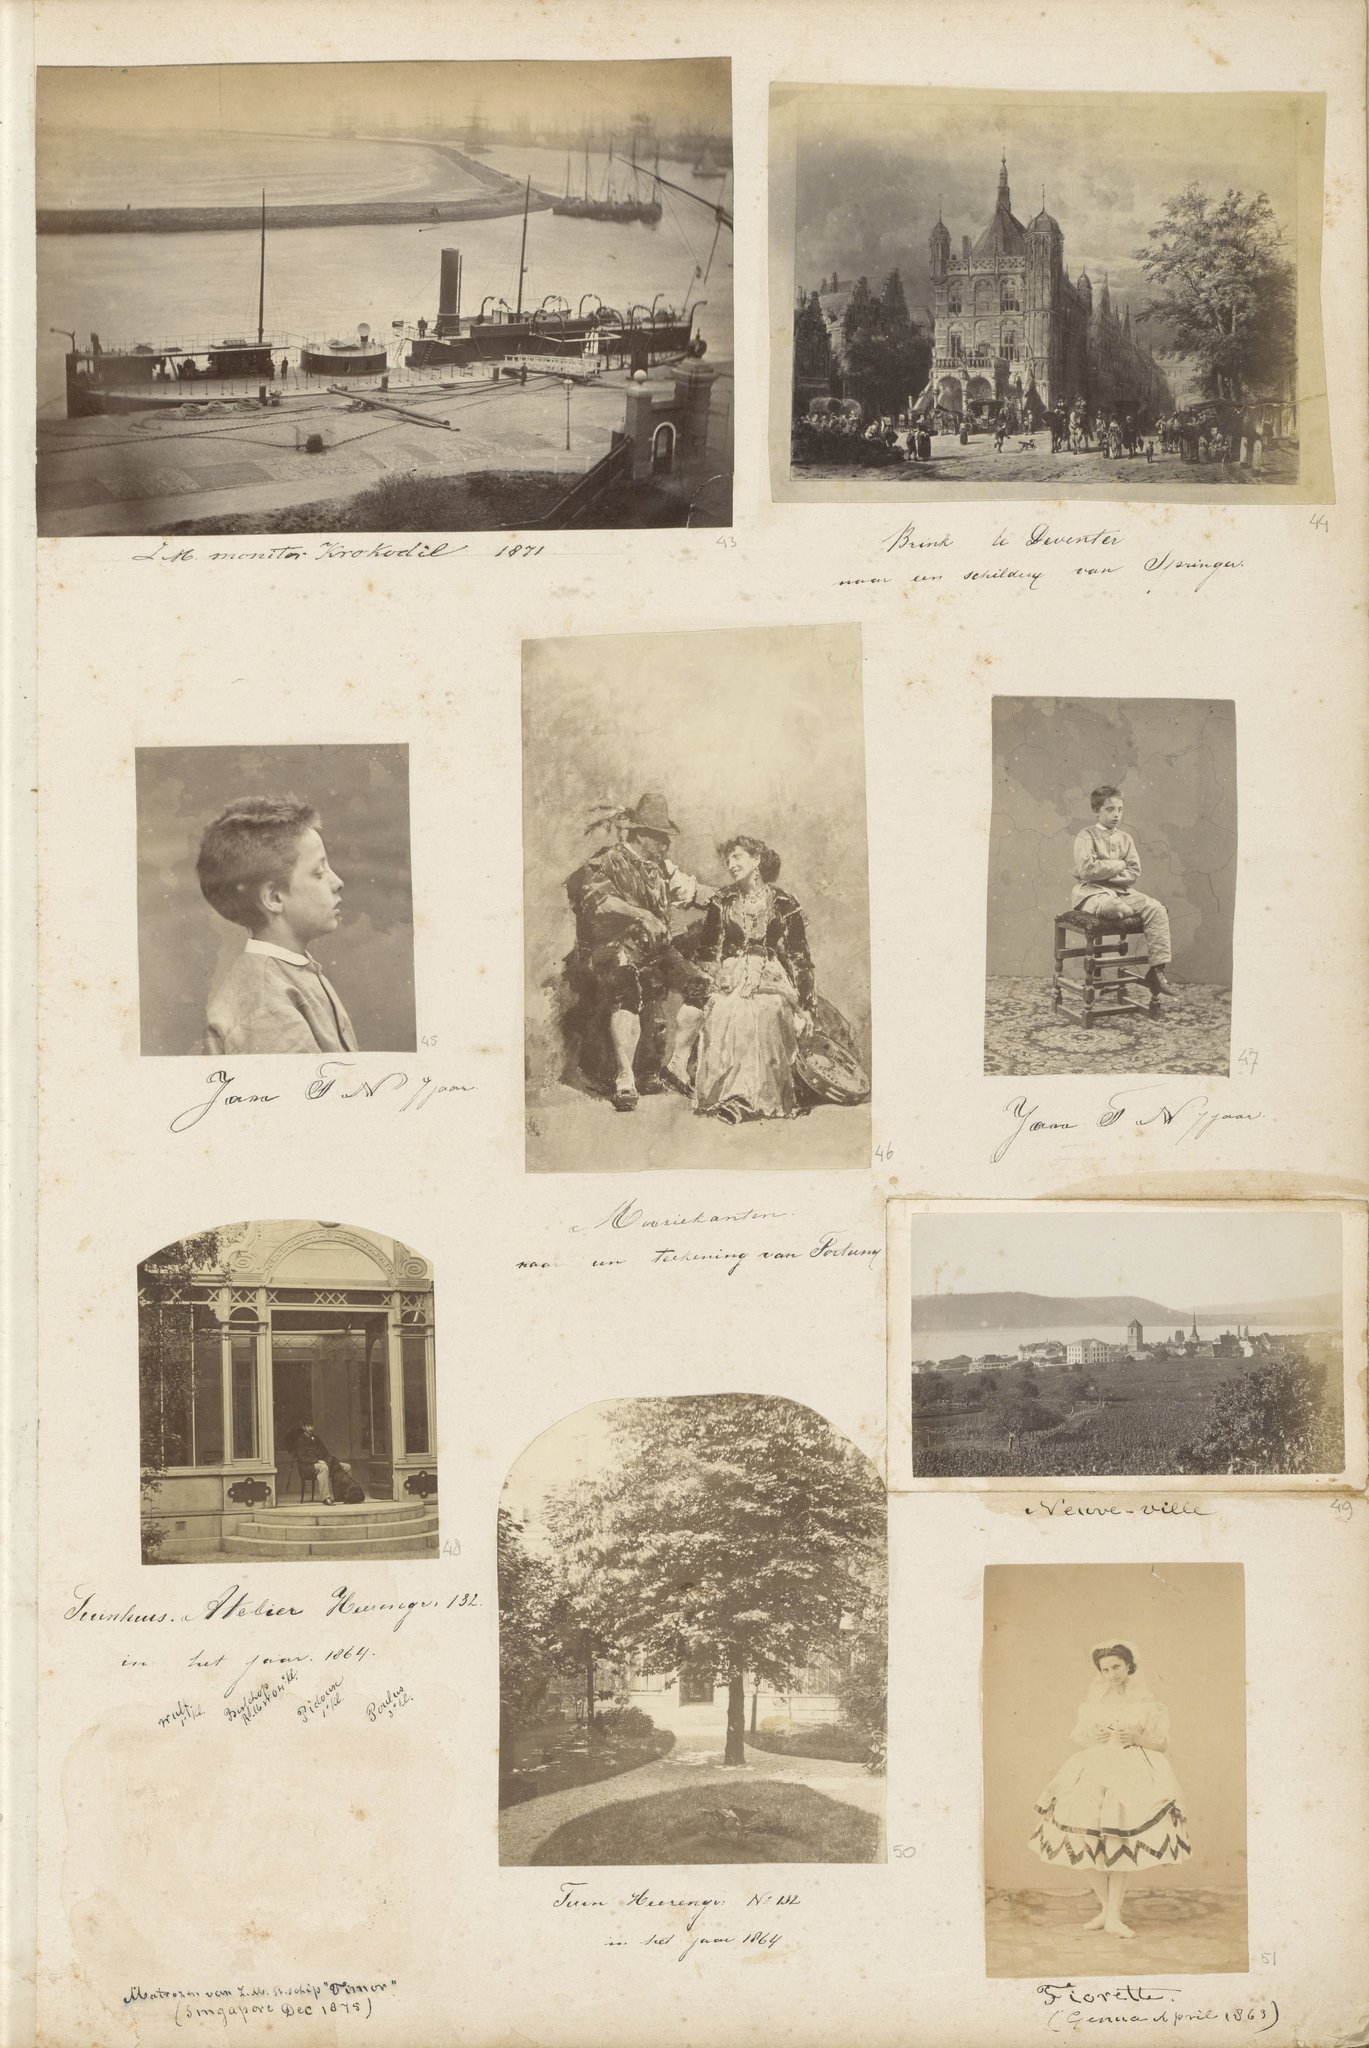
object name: album leaf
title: Portret van een vrouw in een wijduitstaande jurk, aangeduid als Fiorette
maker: Anonymous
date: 1804-1863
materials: paper, photographic support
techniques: albumen print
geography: genoa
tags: adult woman, folk costume, regional costume, dress, gown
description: Onderdeel van Fotoalbum van Robert Daniel Crommelin (1841-1907).